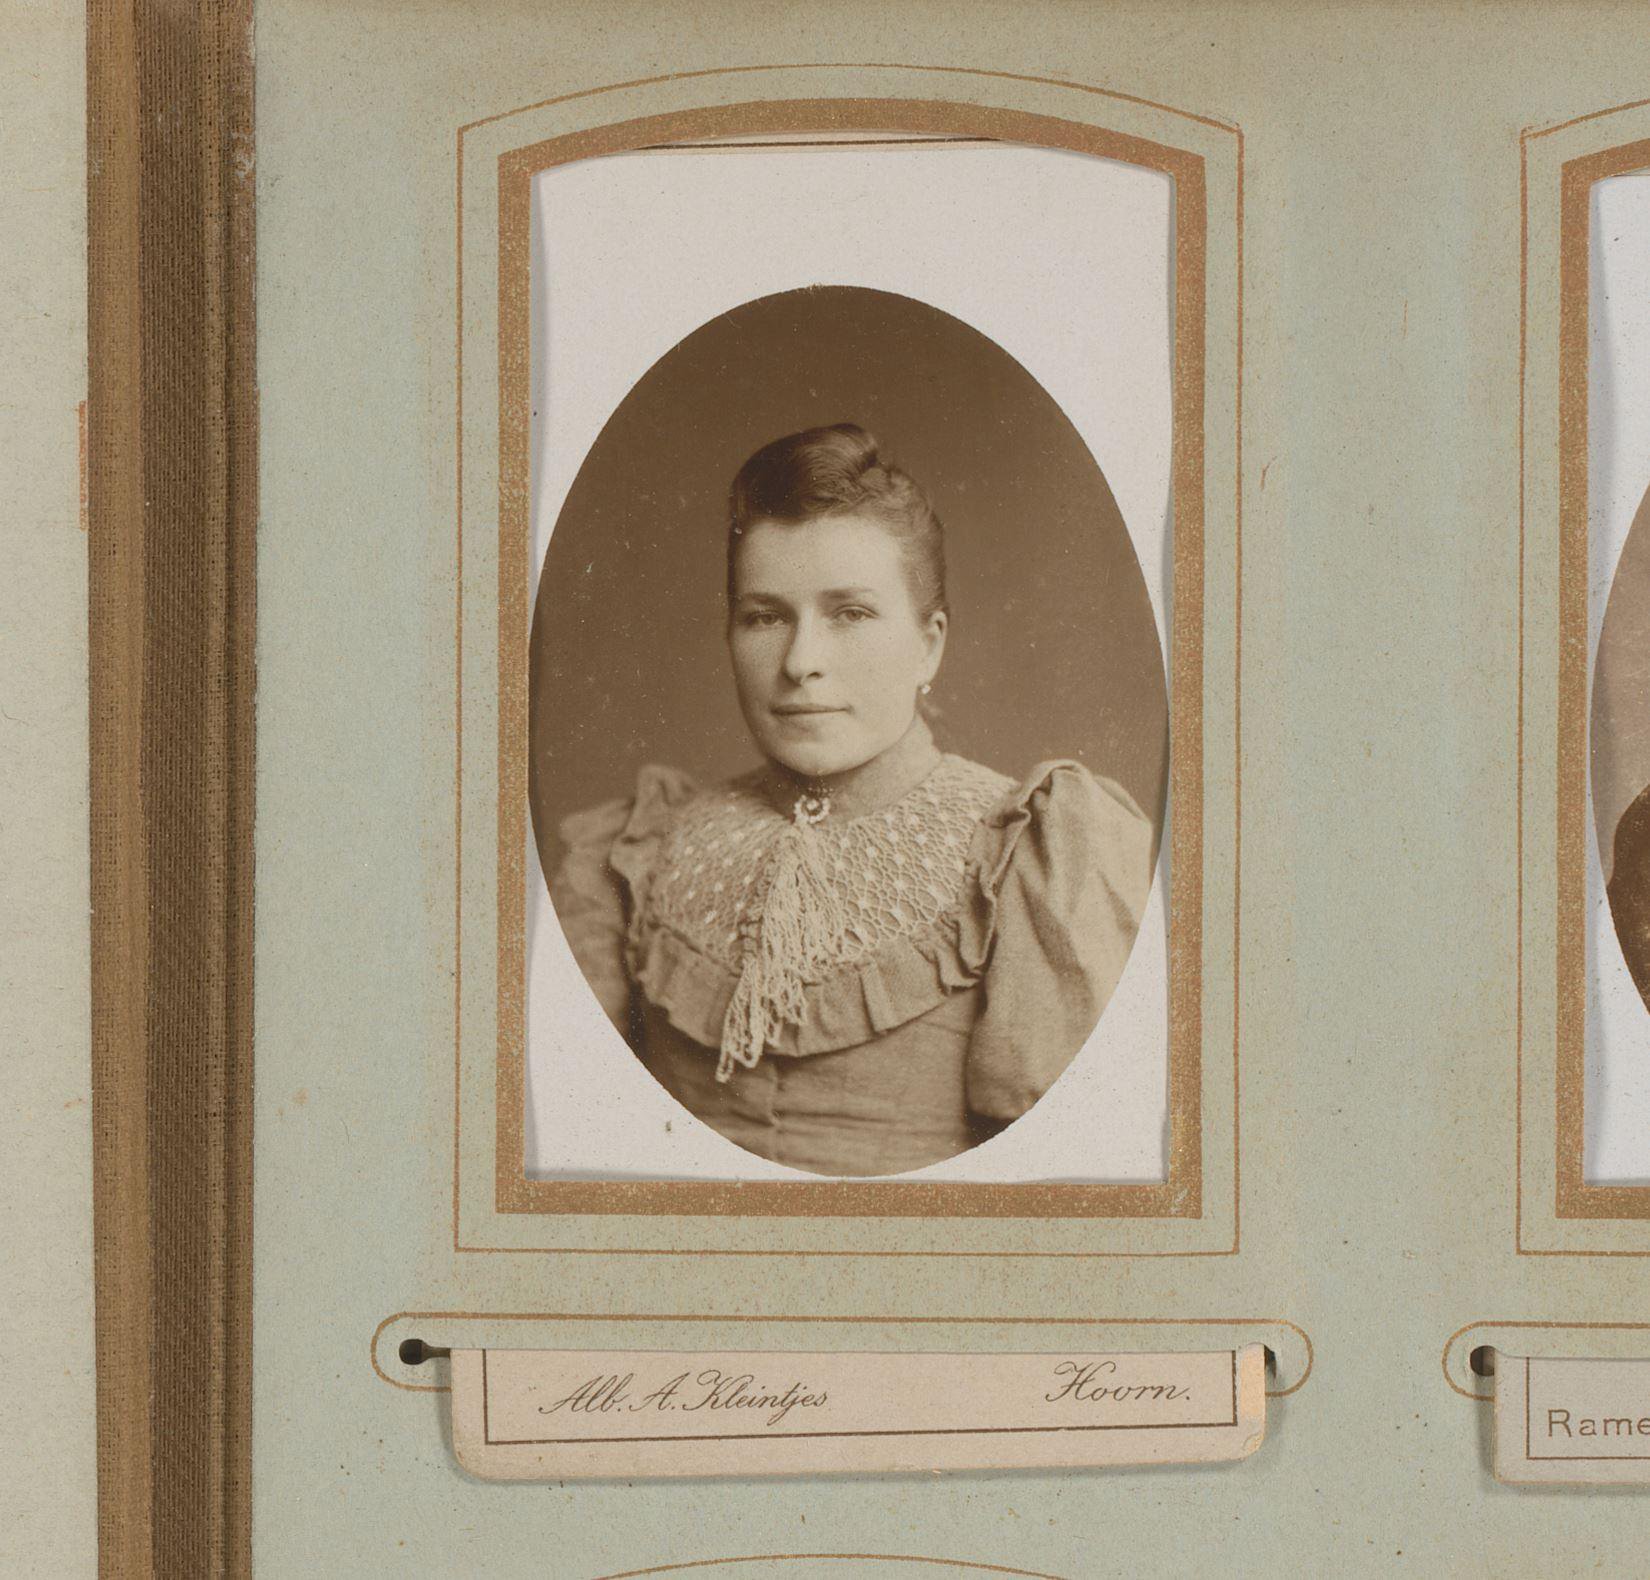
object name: photograph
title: Portret van een vrouw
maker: albert a. kleintjes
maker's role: fotograaf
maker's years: 1854-1942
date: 1883-1913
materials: cardboard, photographic support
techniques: collodion silver print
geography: hoorn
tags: historical persons - bb - woman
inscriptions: inscription: ‘Alb. A. Kleintjes/ Photographe/ Hoorn/ Kerkstraat/ 4e huis v. d. Kaasmarkt./ Nabestellingen en Vergrootingen van deze en andere/ Portretten kunnen ten allen tijde geleverd worden.’